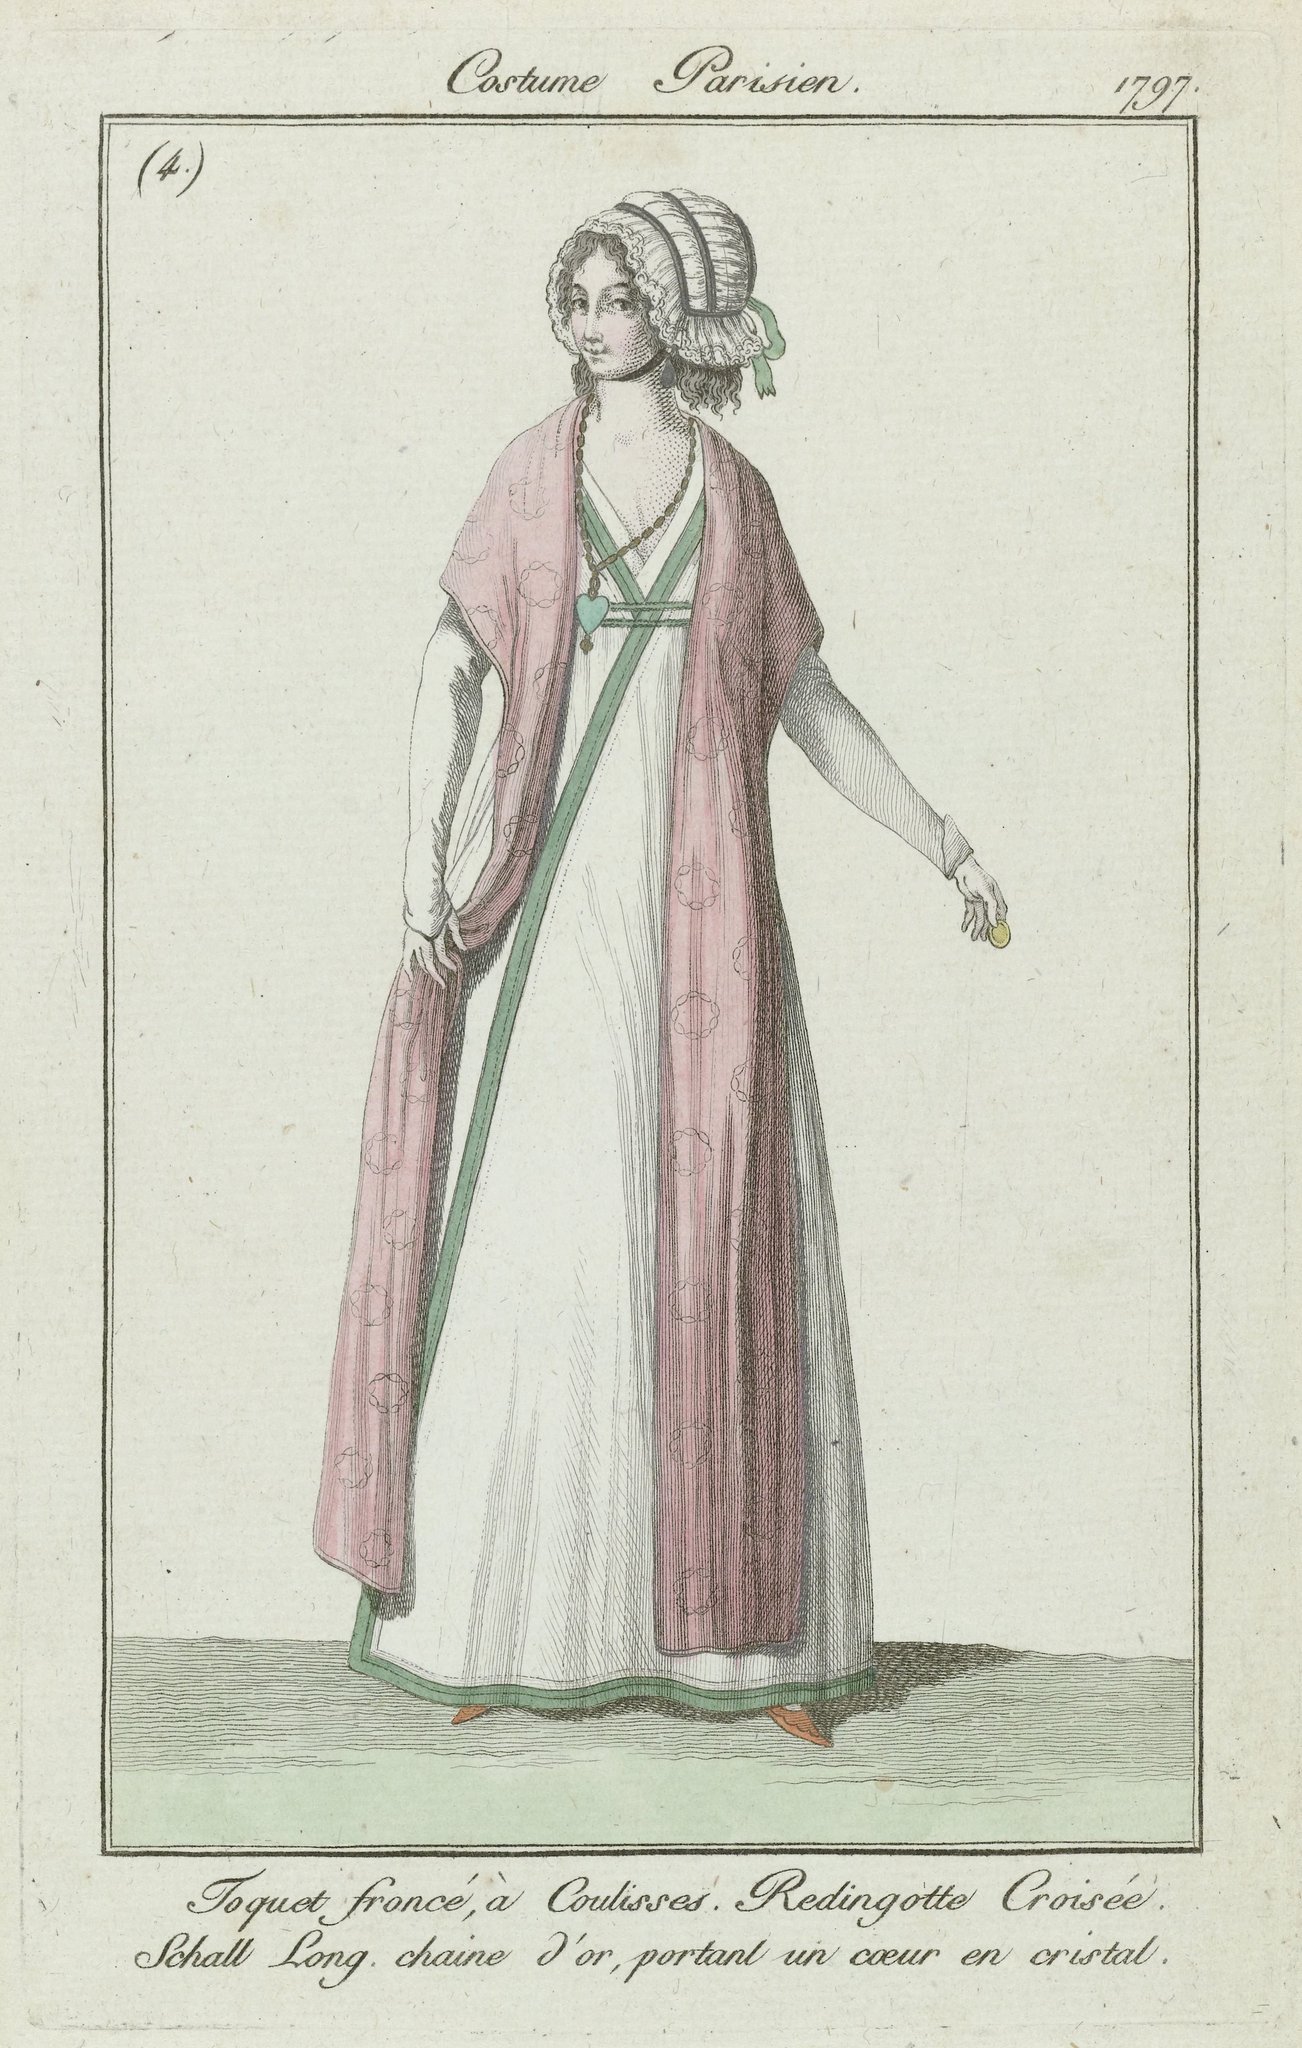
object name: fashion print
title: Journal des Dames et des Modes, Costume Parisien, août 1797, (4) : Toquet froncé à Coulisses (...)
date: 1797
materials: paper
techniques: engraving, hand coloring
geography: paris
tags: ear-rings (+ women's clothes), head-gear: toque (+ women's clothes), clothing for the upper part of the body (shawl) (+ women's clothes), dress, gown: redingote (+ women's clothes), fashion plates, shoes, sandals (+ women's clothes), coin, necklace (+ women's clothes)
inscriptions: caption: ‘Toquet froncé à Coulisses. Redingotte Croisée. Schall Long. chaine d'or, portant un coeur en cristal.’, title: ‘Costume Parisien.’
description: Staande vrouw met op het hoofd een 'toquet', aan de achterzijde gesmockt. Zij draagt een redingote met overslag. Om de schouders een lange sjaal met cirkelmotief. Gouden collier met hartvormige hanger van kristal. Verdere accessoires: oorbel in het linkeroor, munt (?), schoenen met puntige neuzen. De prent maakt deel uit van het modetijdschrift Journal des Dames et des Modes, uitgegeven door Sellèque, Parijs, 1797-1839. De prent werd eerder uitgegeven in het Journal des Modes et Nouveautés als nummer 4, met het onderschrift 'Costumes'.